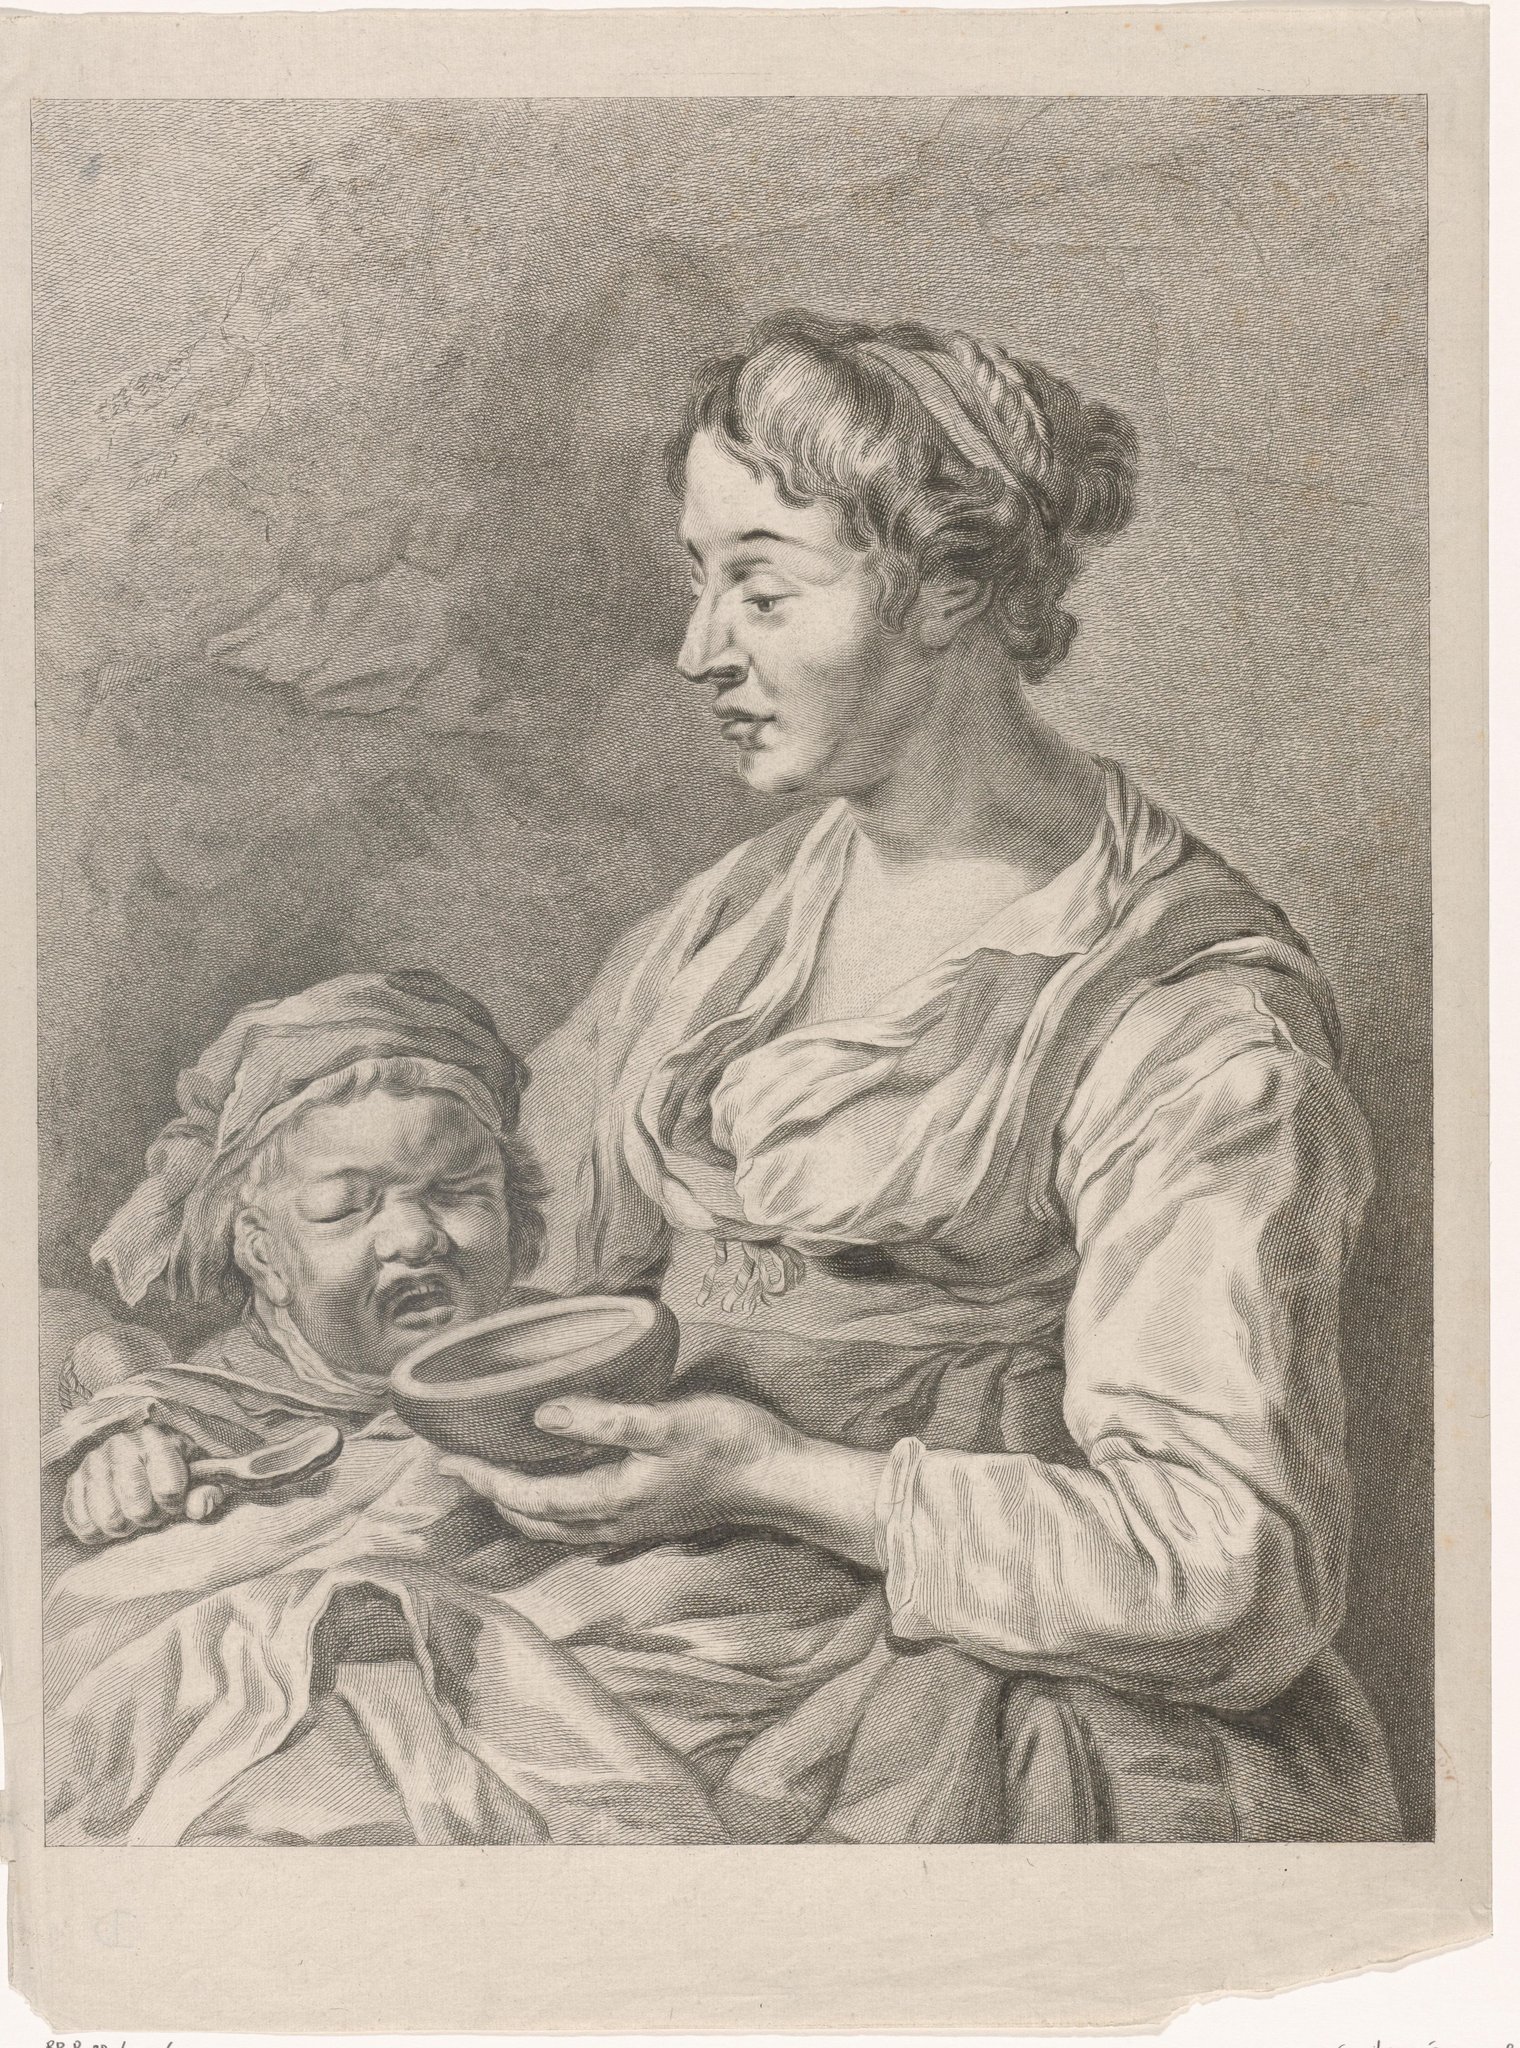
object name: print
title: Moeder geeft haar kind te eten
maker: pieter de mare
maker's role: print maker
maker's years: 1758-1796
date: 1786-1796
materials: paper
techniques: printmaking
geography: leiden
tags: feeding a baby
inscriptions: collector's mark: Lugt 240